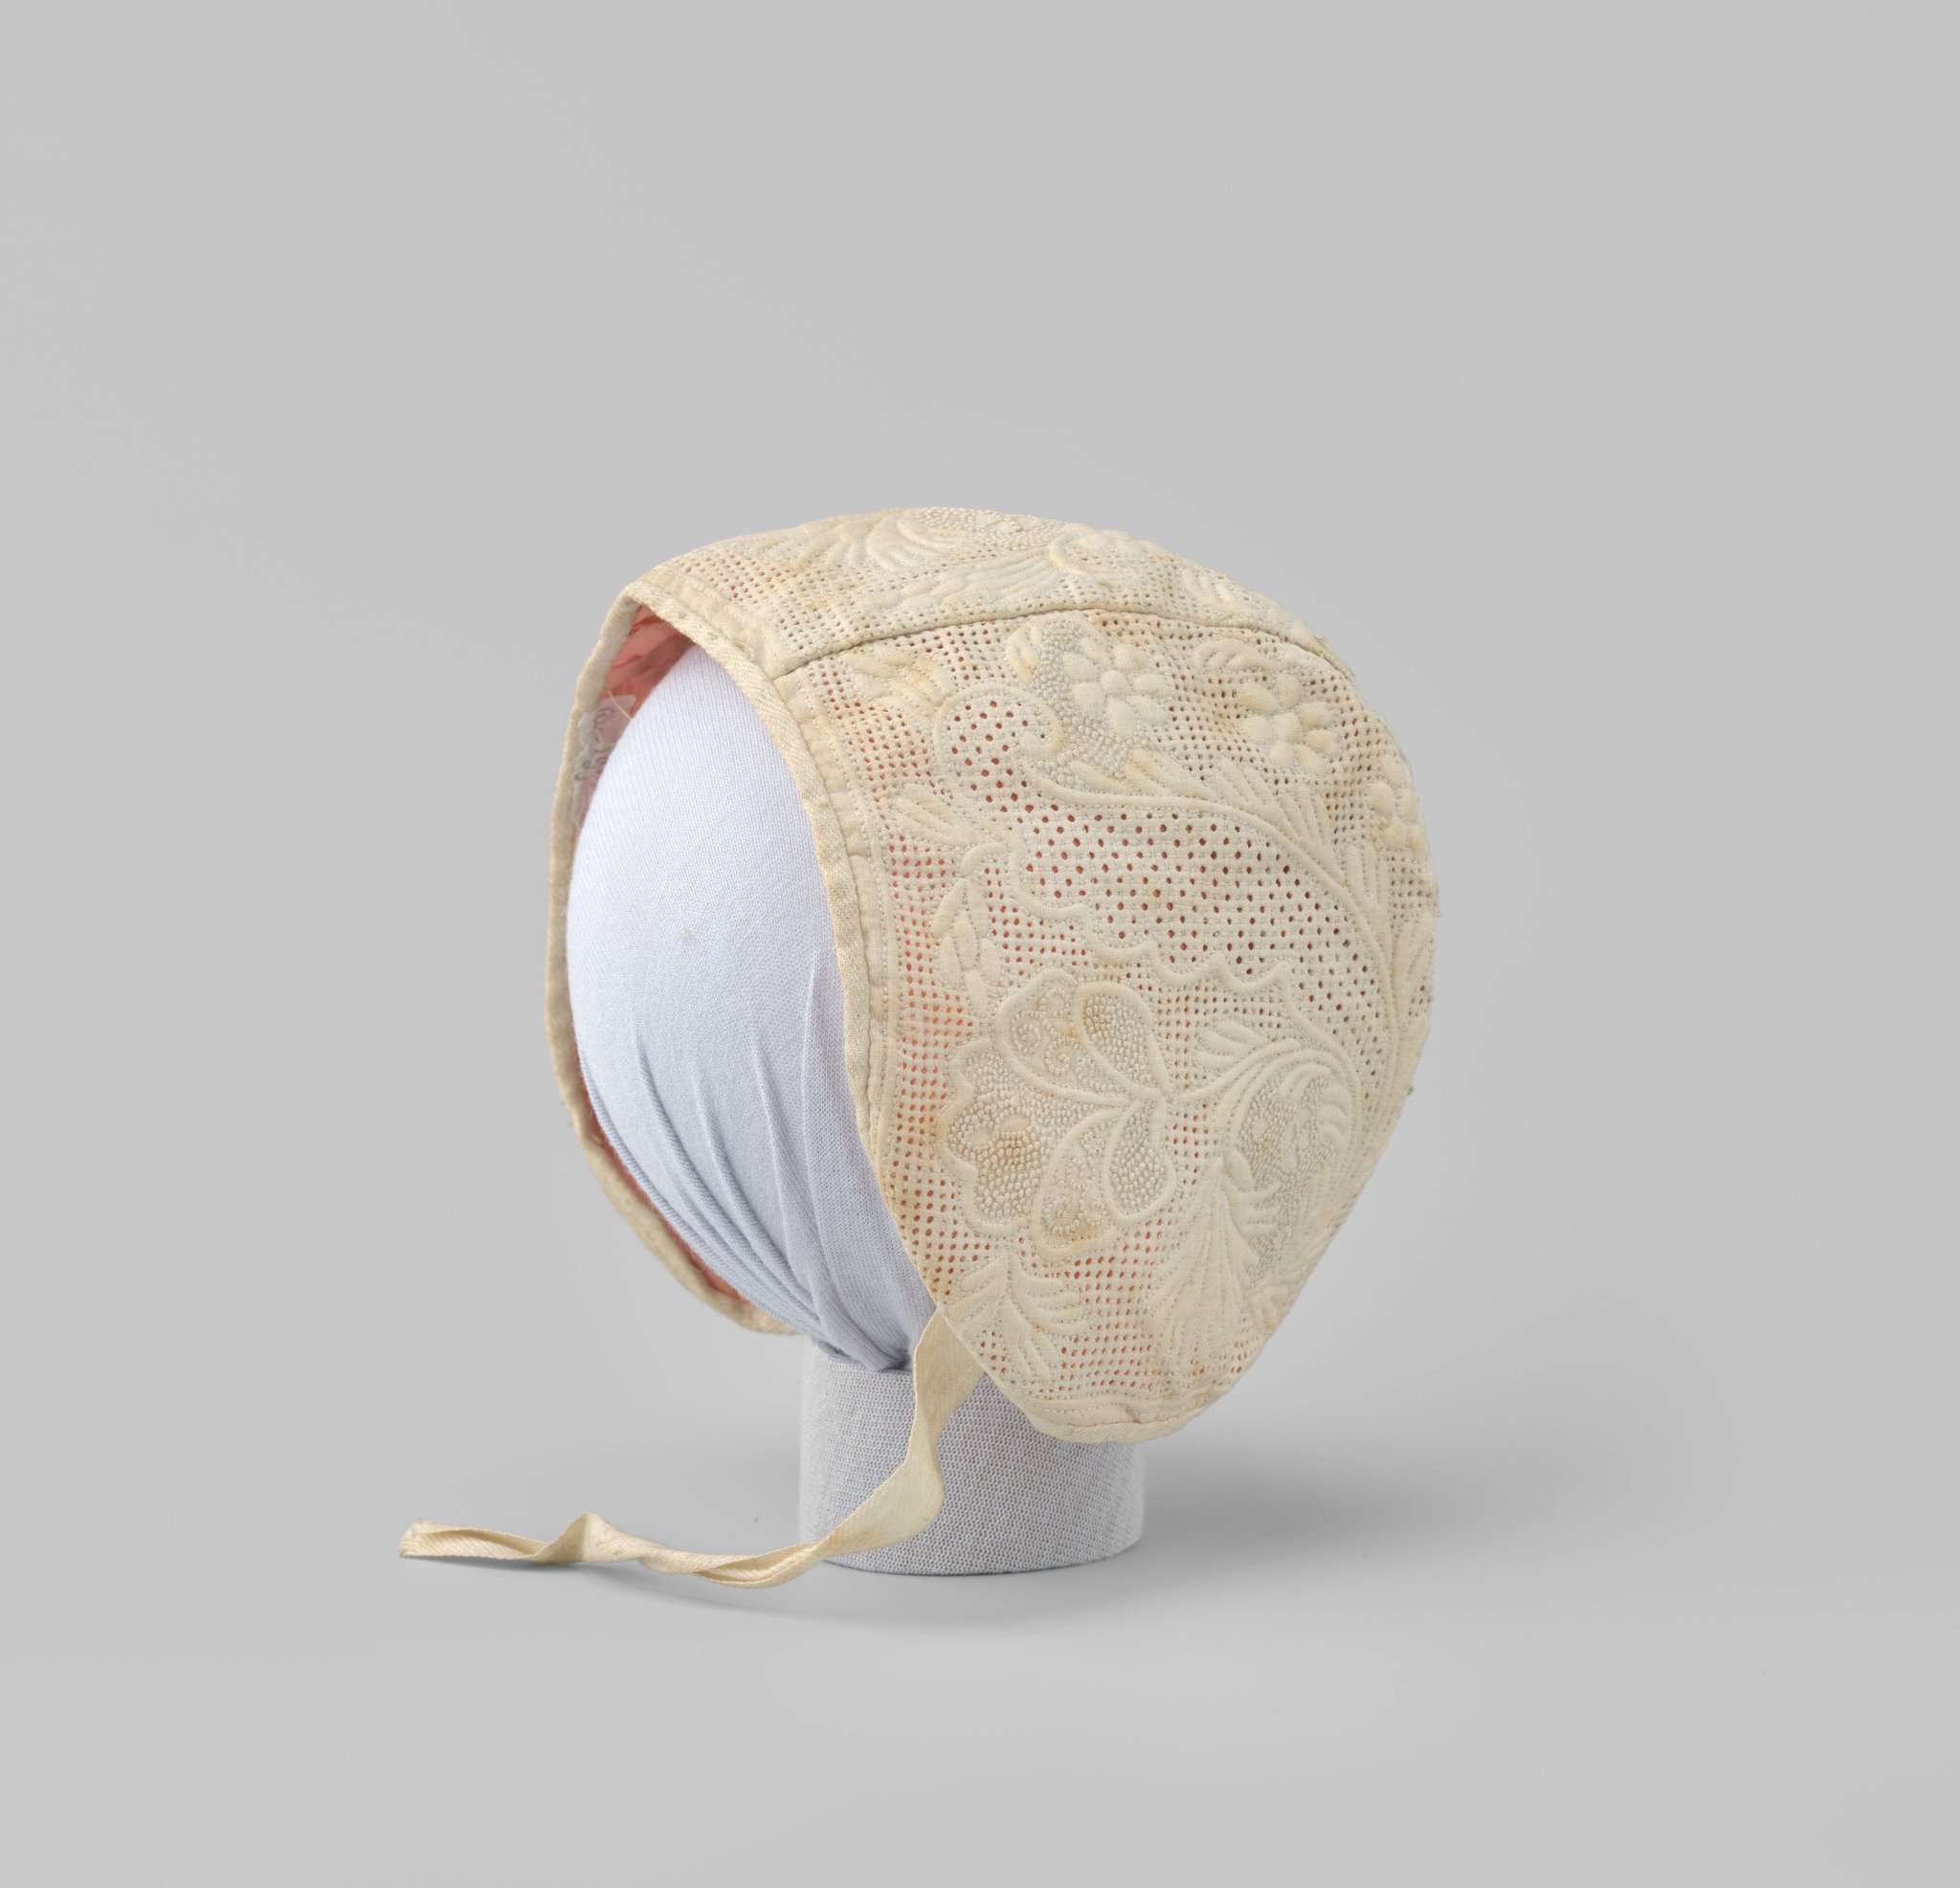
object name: babymuts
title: Babymuts van linnen met Zaans stikwerk op een opengewerkt fond; voering van roze zijde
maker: Anonymous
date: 1725-1750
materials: linen, silk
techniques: quilted embroidery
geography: netherlands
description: Driedelige babymuts voor een meisje. Linnen met Zaans stikwerk en open naaiwerk, gevoerd met roze zijde. Dessin van grote gevederde bladeren, anjers en palmetten.